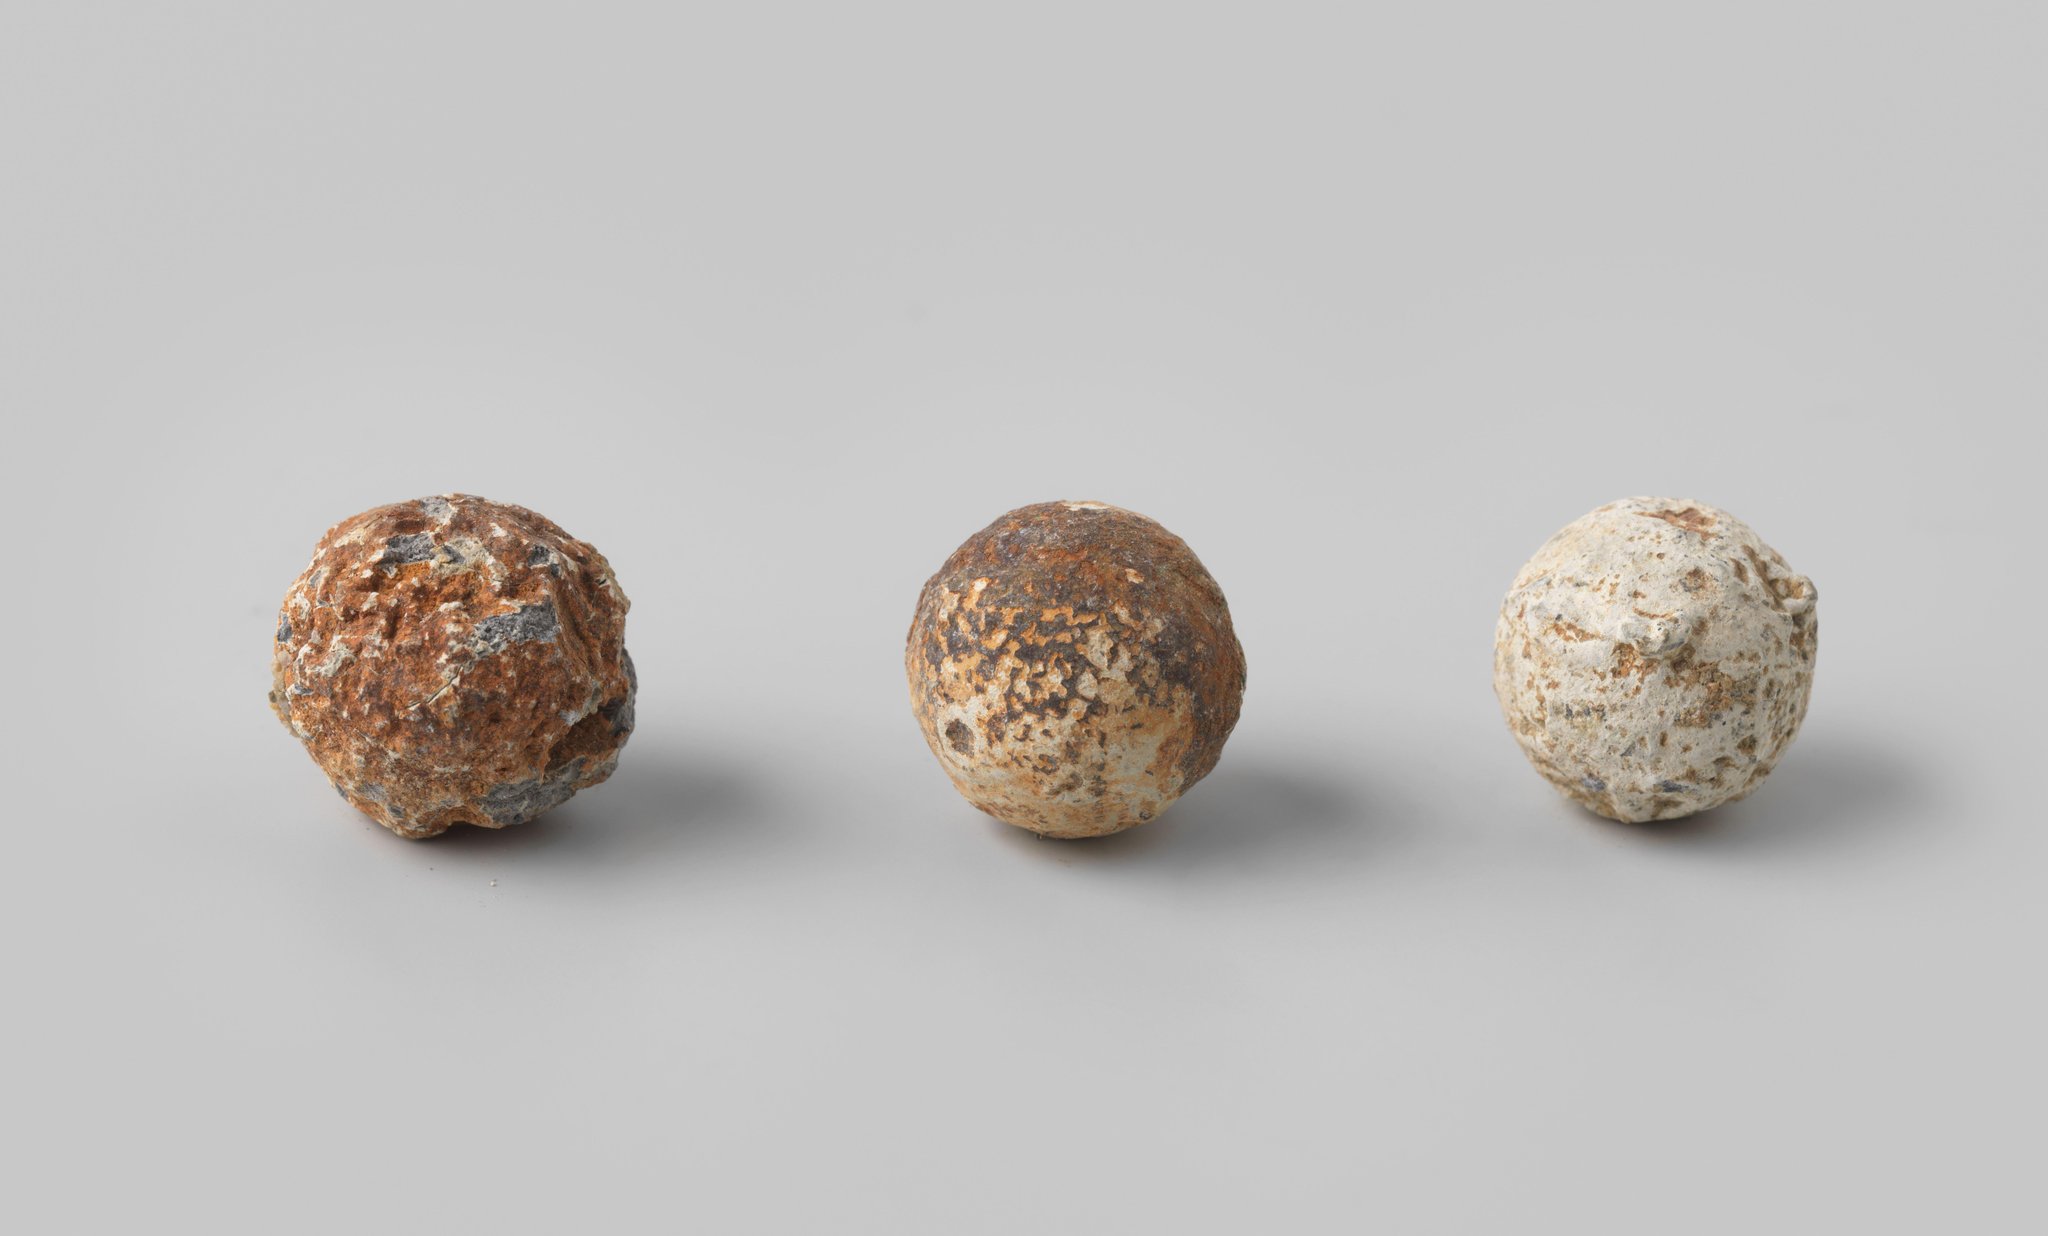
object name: musketkogel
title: Musketkogels uit het wrak van de Oost-Indiëvaarder Hollandia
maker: Anonymous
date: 1700-1743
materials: lead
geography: netherlands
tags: verenigde oostindische compagnie, hollandia (schip), annet